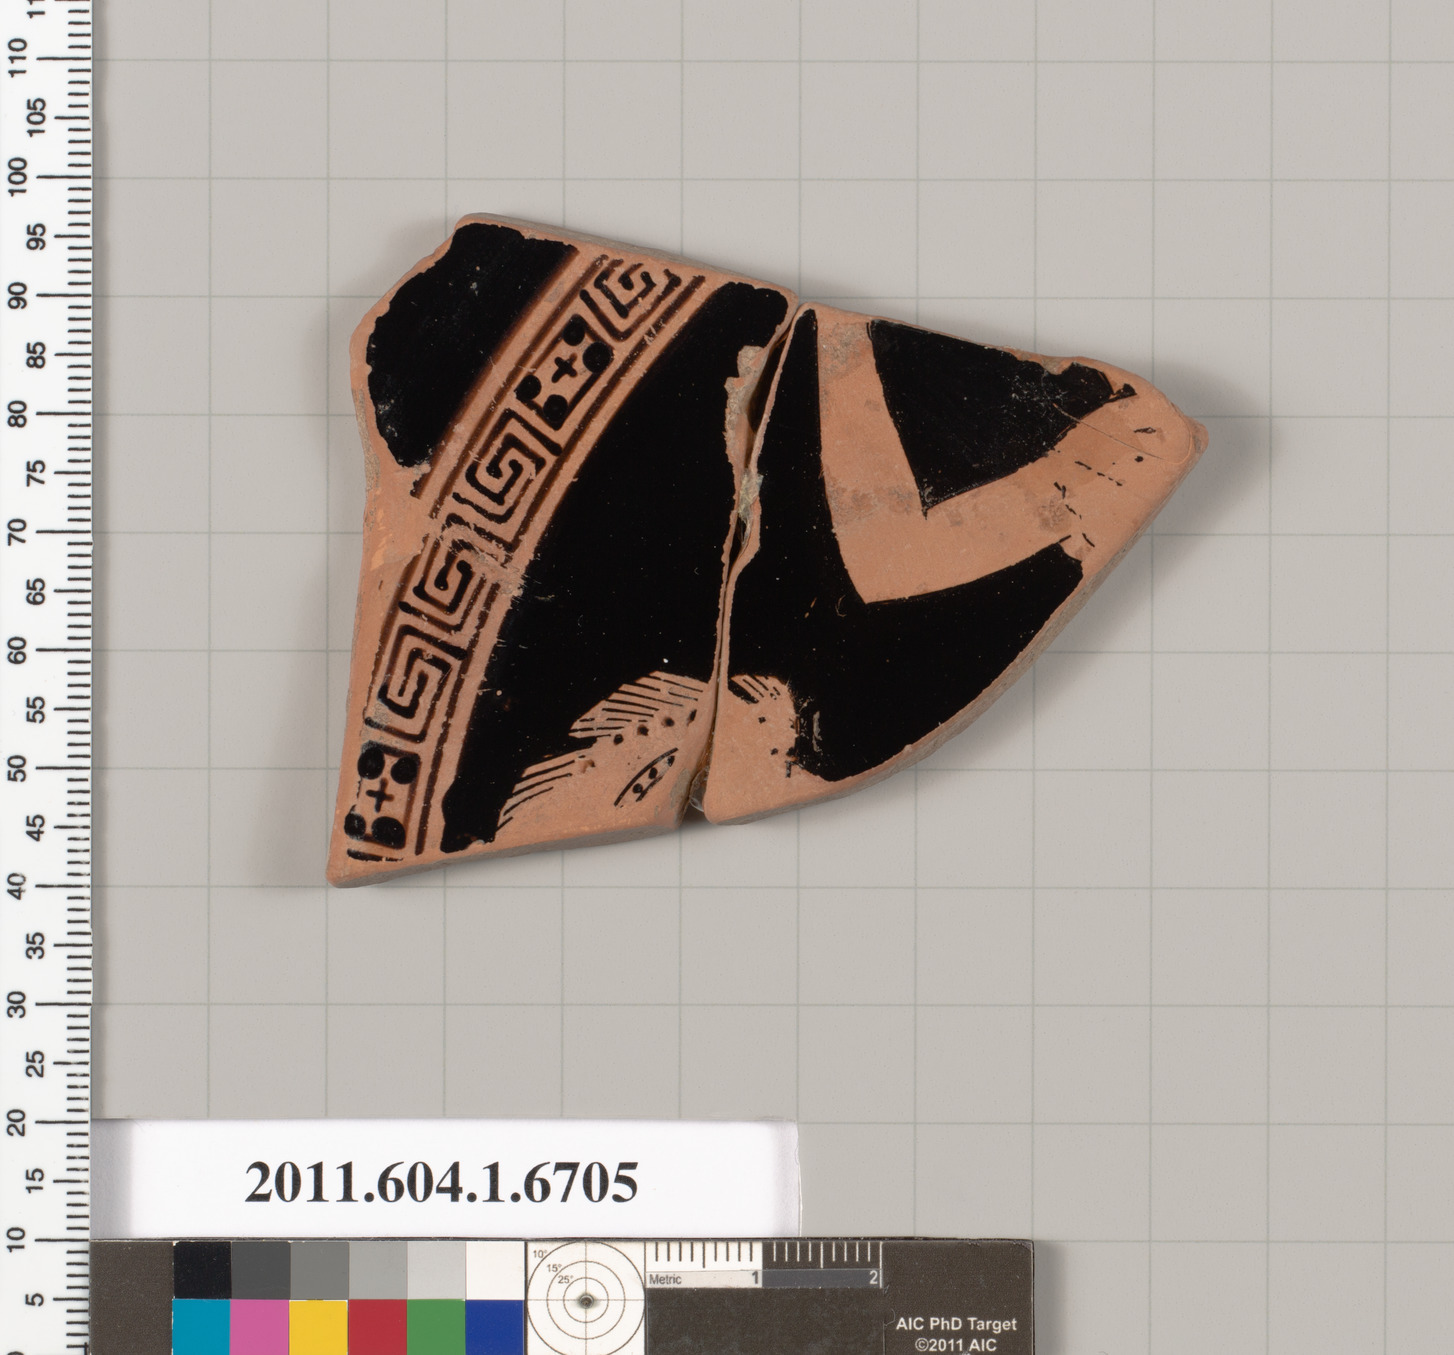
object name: kylix fragment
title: Terracotta fragment of a kylix (drinking cup)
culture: greek, attic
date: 490-470 BCE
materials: terracotta